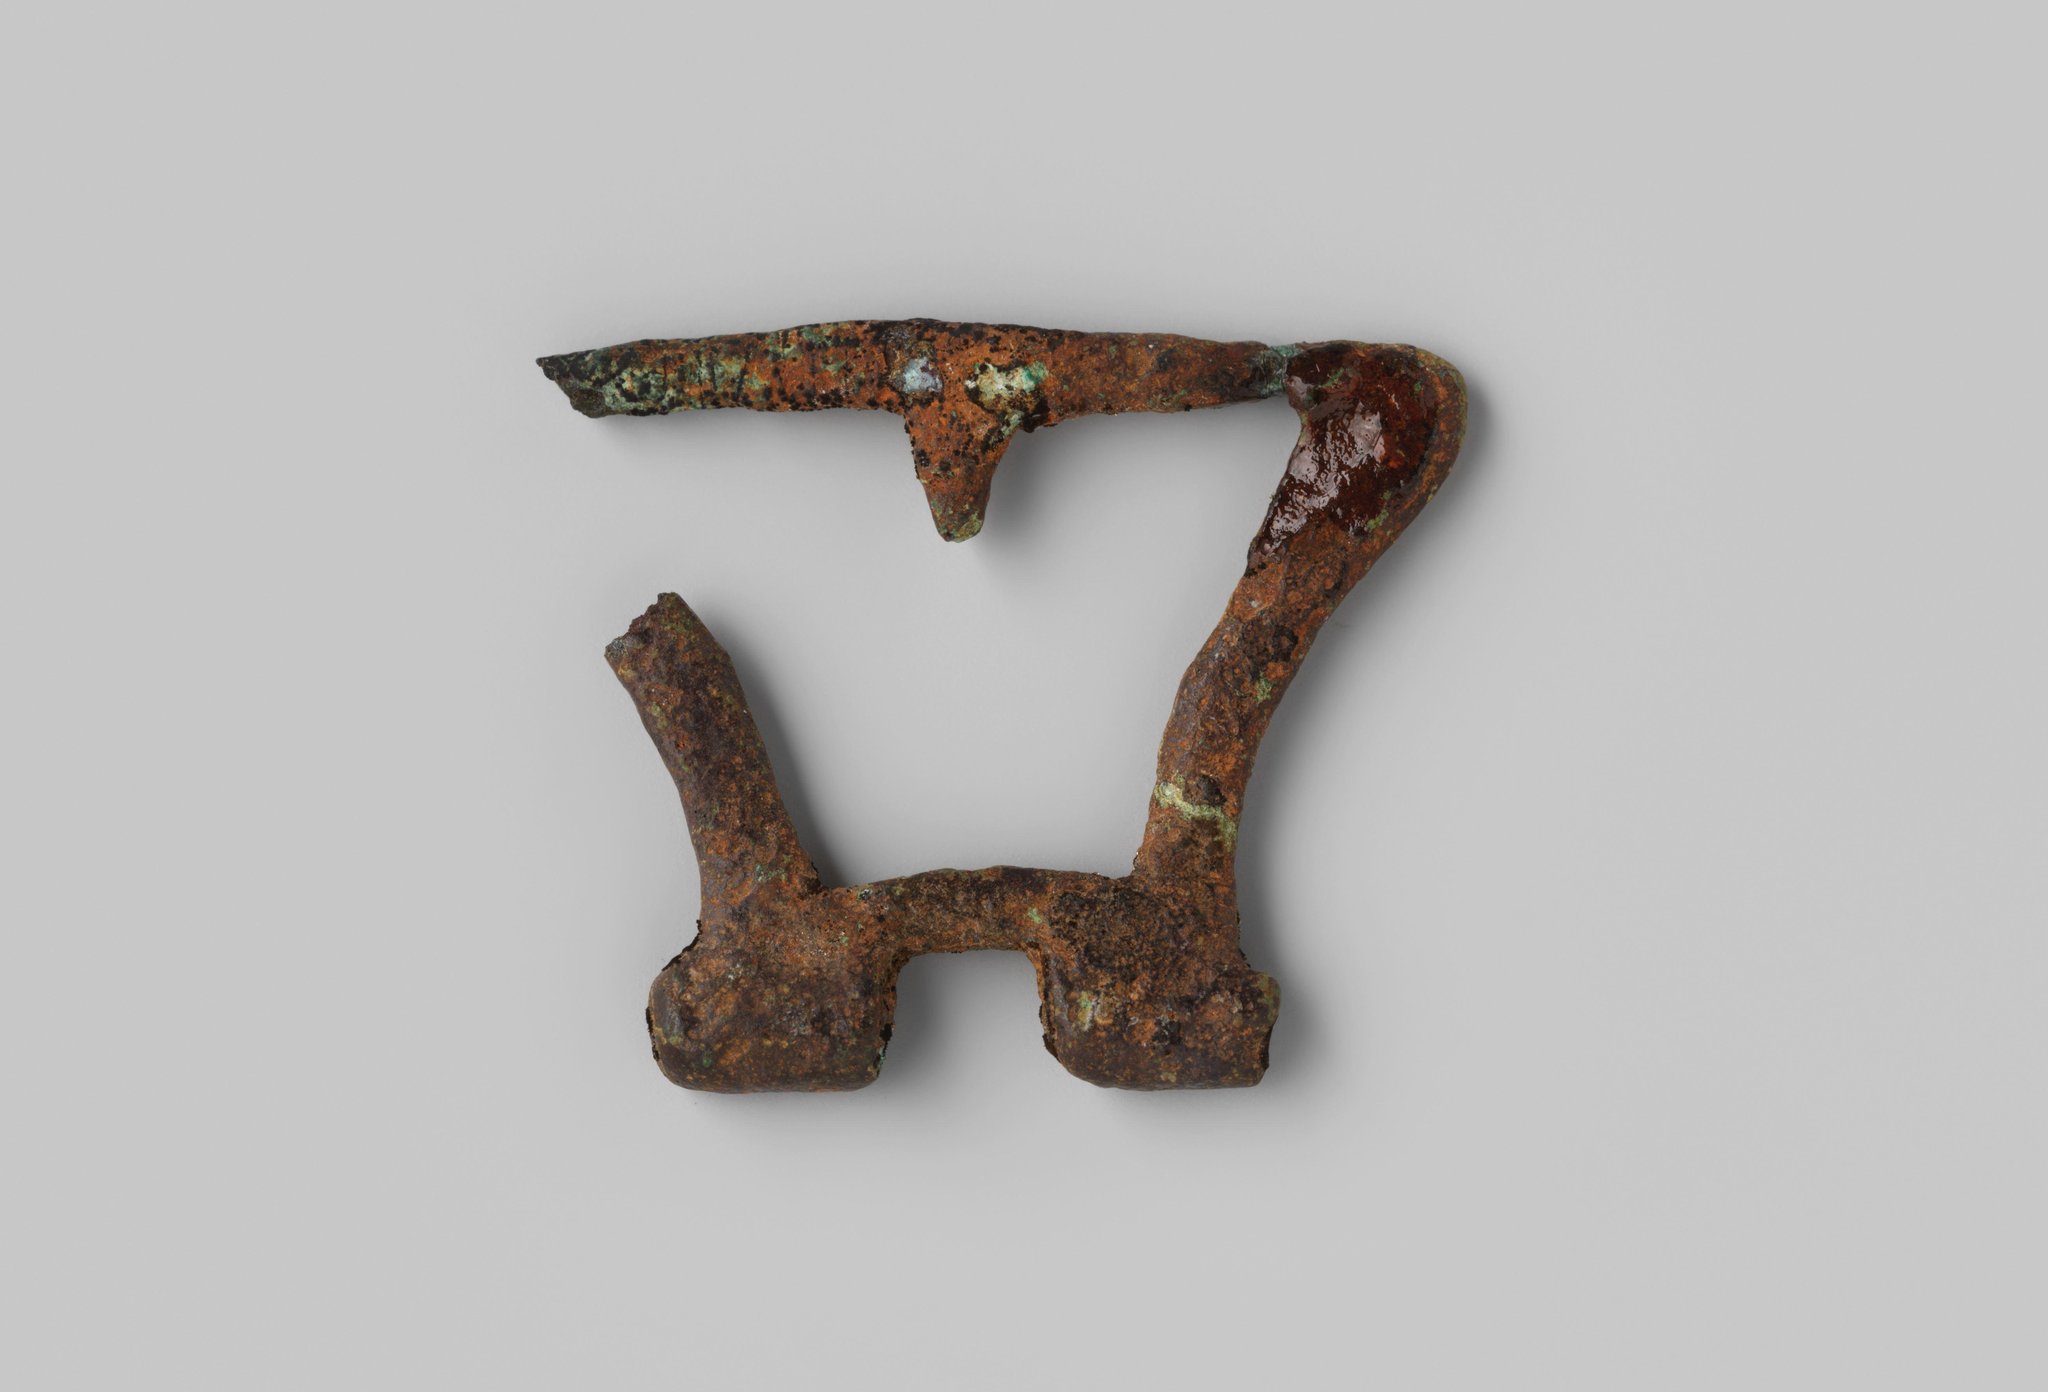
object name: buckle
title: Fragment van een gesp uit het wrak van de Oost-Indiëvaarder Hollandia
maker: Anonymous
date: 1700-1743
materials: copper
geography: netherlands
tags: verenigde oostindische compagnie, hollandia (schip), annet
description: Fragm of single-pronged loop, triangular, id. in buckle NG 1980-27H2930.